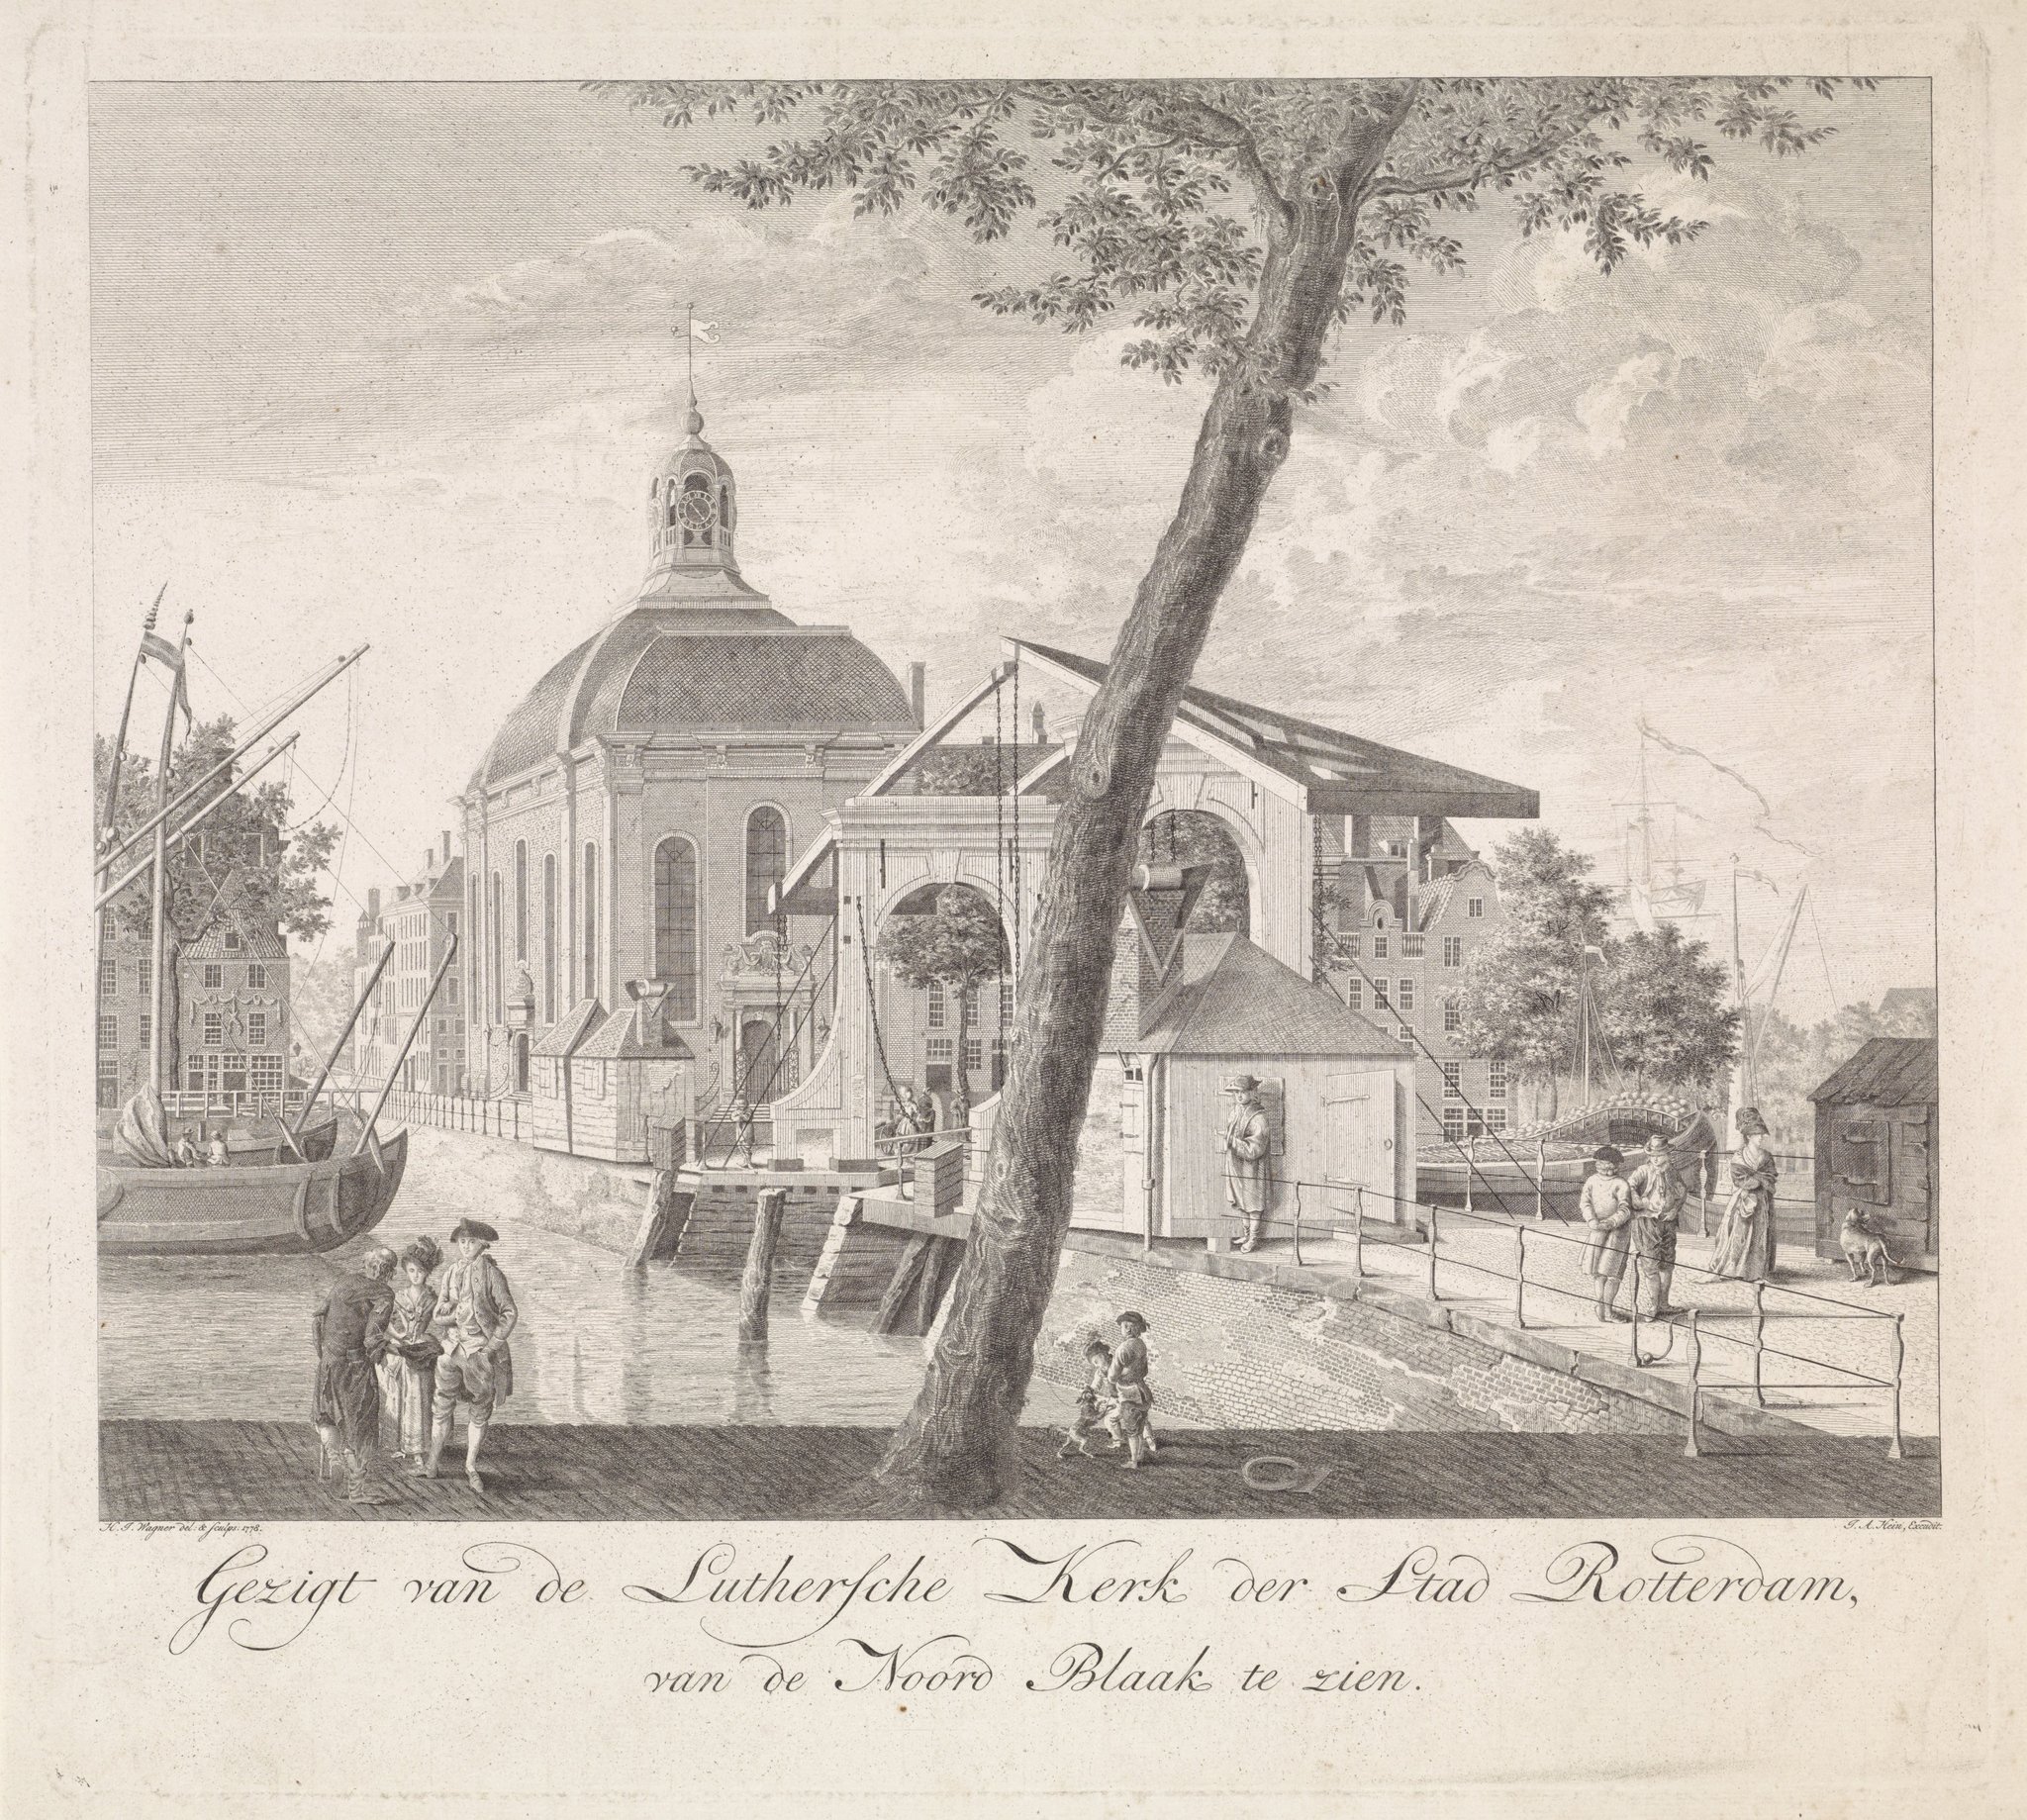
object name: print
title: Gezicht op de Lutherse Kerk te Rotterdam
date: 1778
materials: paper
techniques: engraving, etching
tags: lutherse kerk, leuvehaven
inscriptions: collector's mark: Lugt 2228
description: Gezicht op de Lutherse Kerk aan het Wolfshoek te Rotterdam, gezien vanuit de richting van de Blaak. Links de Leuvehaven met de Keizersbrug of Houtbrug en in het verlengde de Posthoornsteeg.